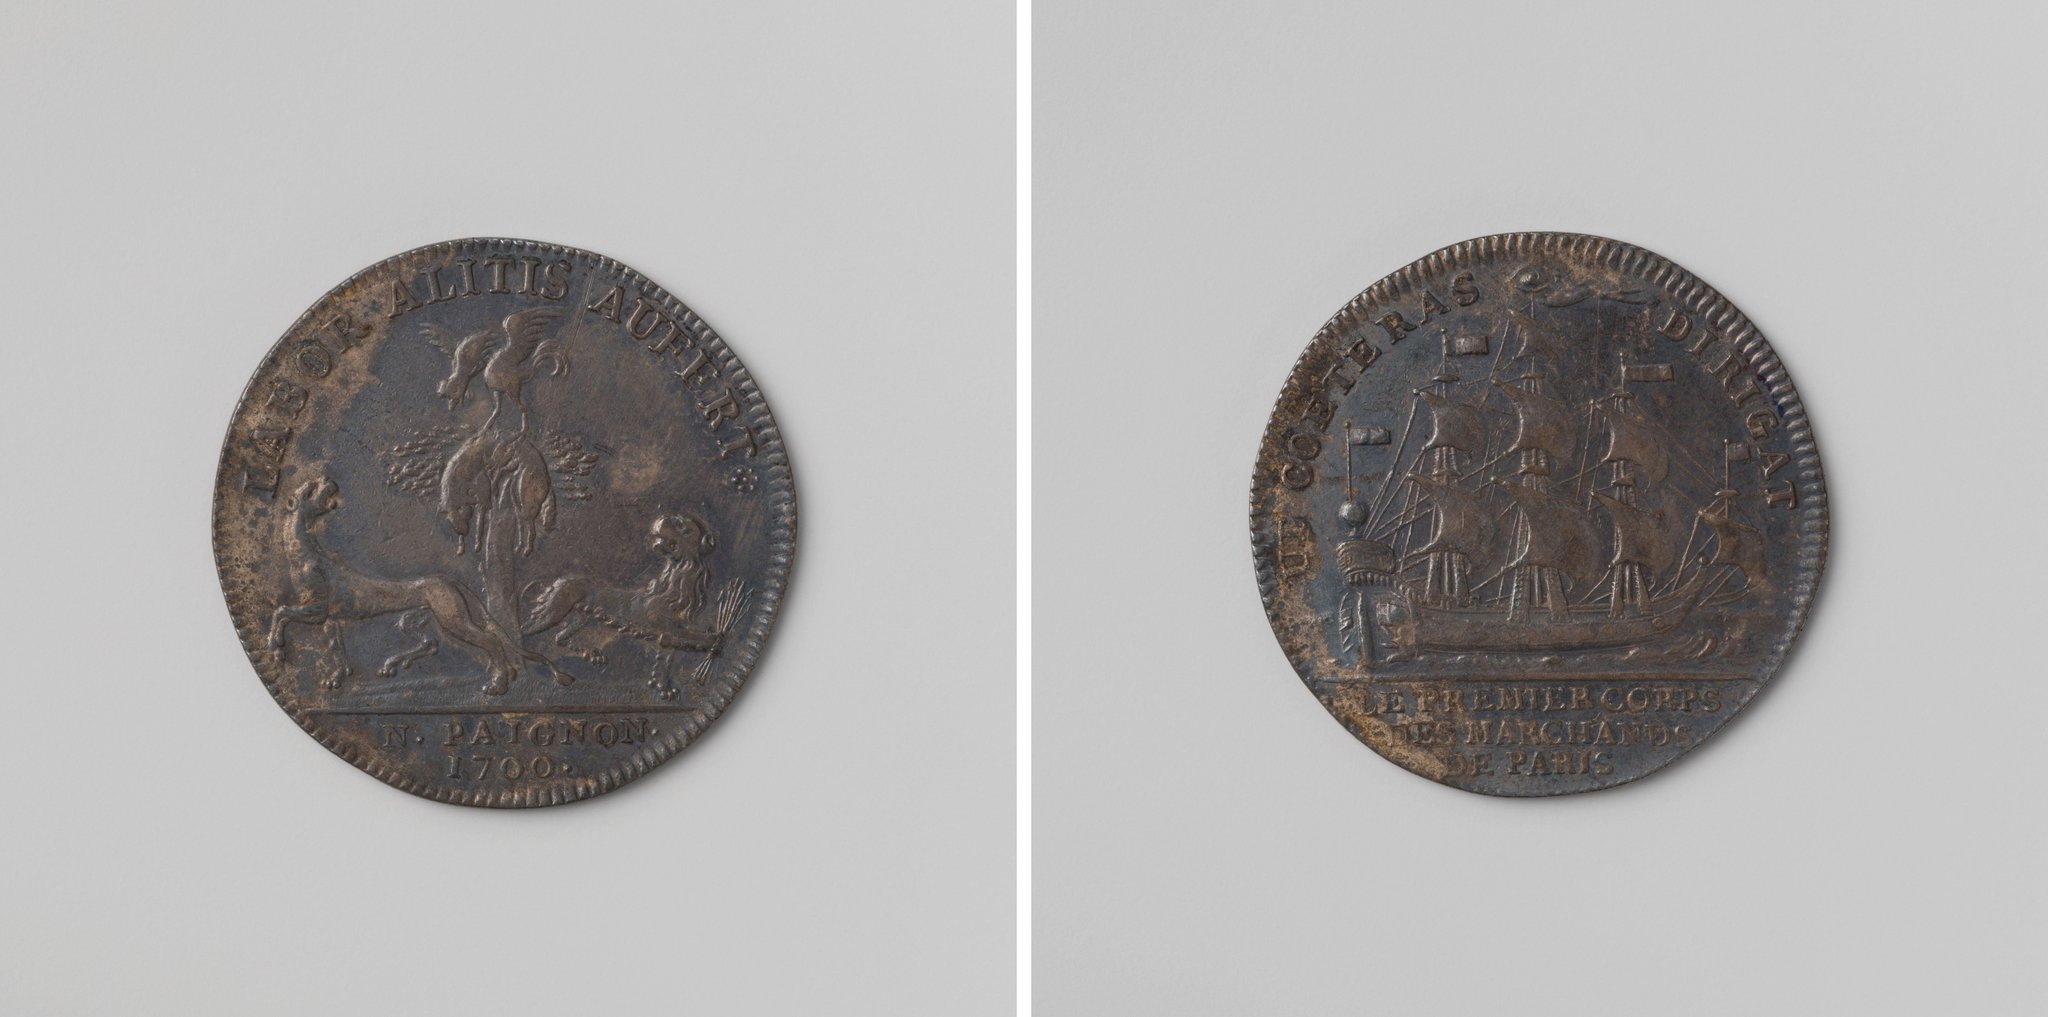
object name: jeton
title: Filips van Anjou accepteert de Spaanse troon, rekenpenning geslagen ter ere van N. Paignon, van het eerste provoostschap van de koophandel te Parijs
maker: Anonymous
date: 1700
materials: silver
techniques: striking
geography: france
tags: filips v (koning van spanje), paris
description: Zilveren penning. Voorzijde: Franse haan maakt zich meester van Gulden Vlies, dat aan Spaanse granaatboom hangt en tevergeefs bewaakt wordt door luipaard en leeuw met pijlenbundel in klauw binnen omschrift; afsnede: opschrift. Keerzijde: schip op zee onder alziend oog binnen omschrift